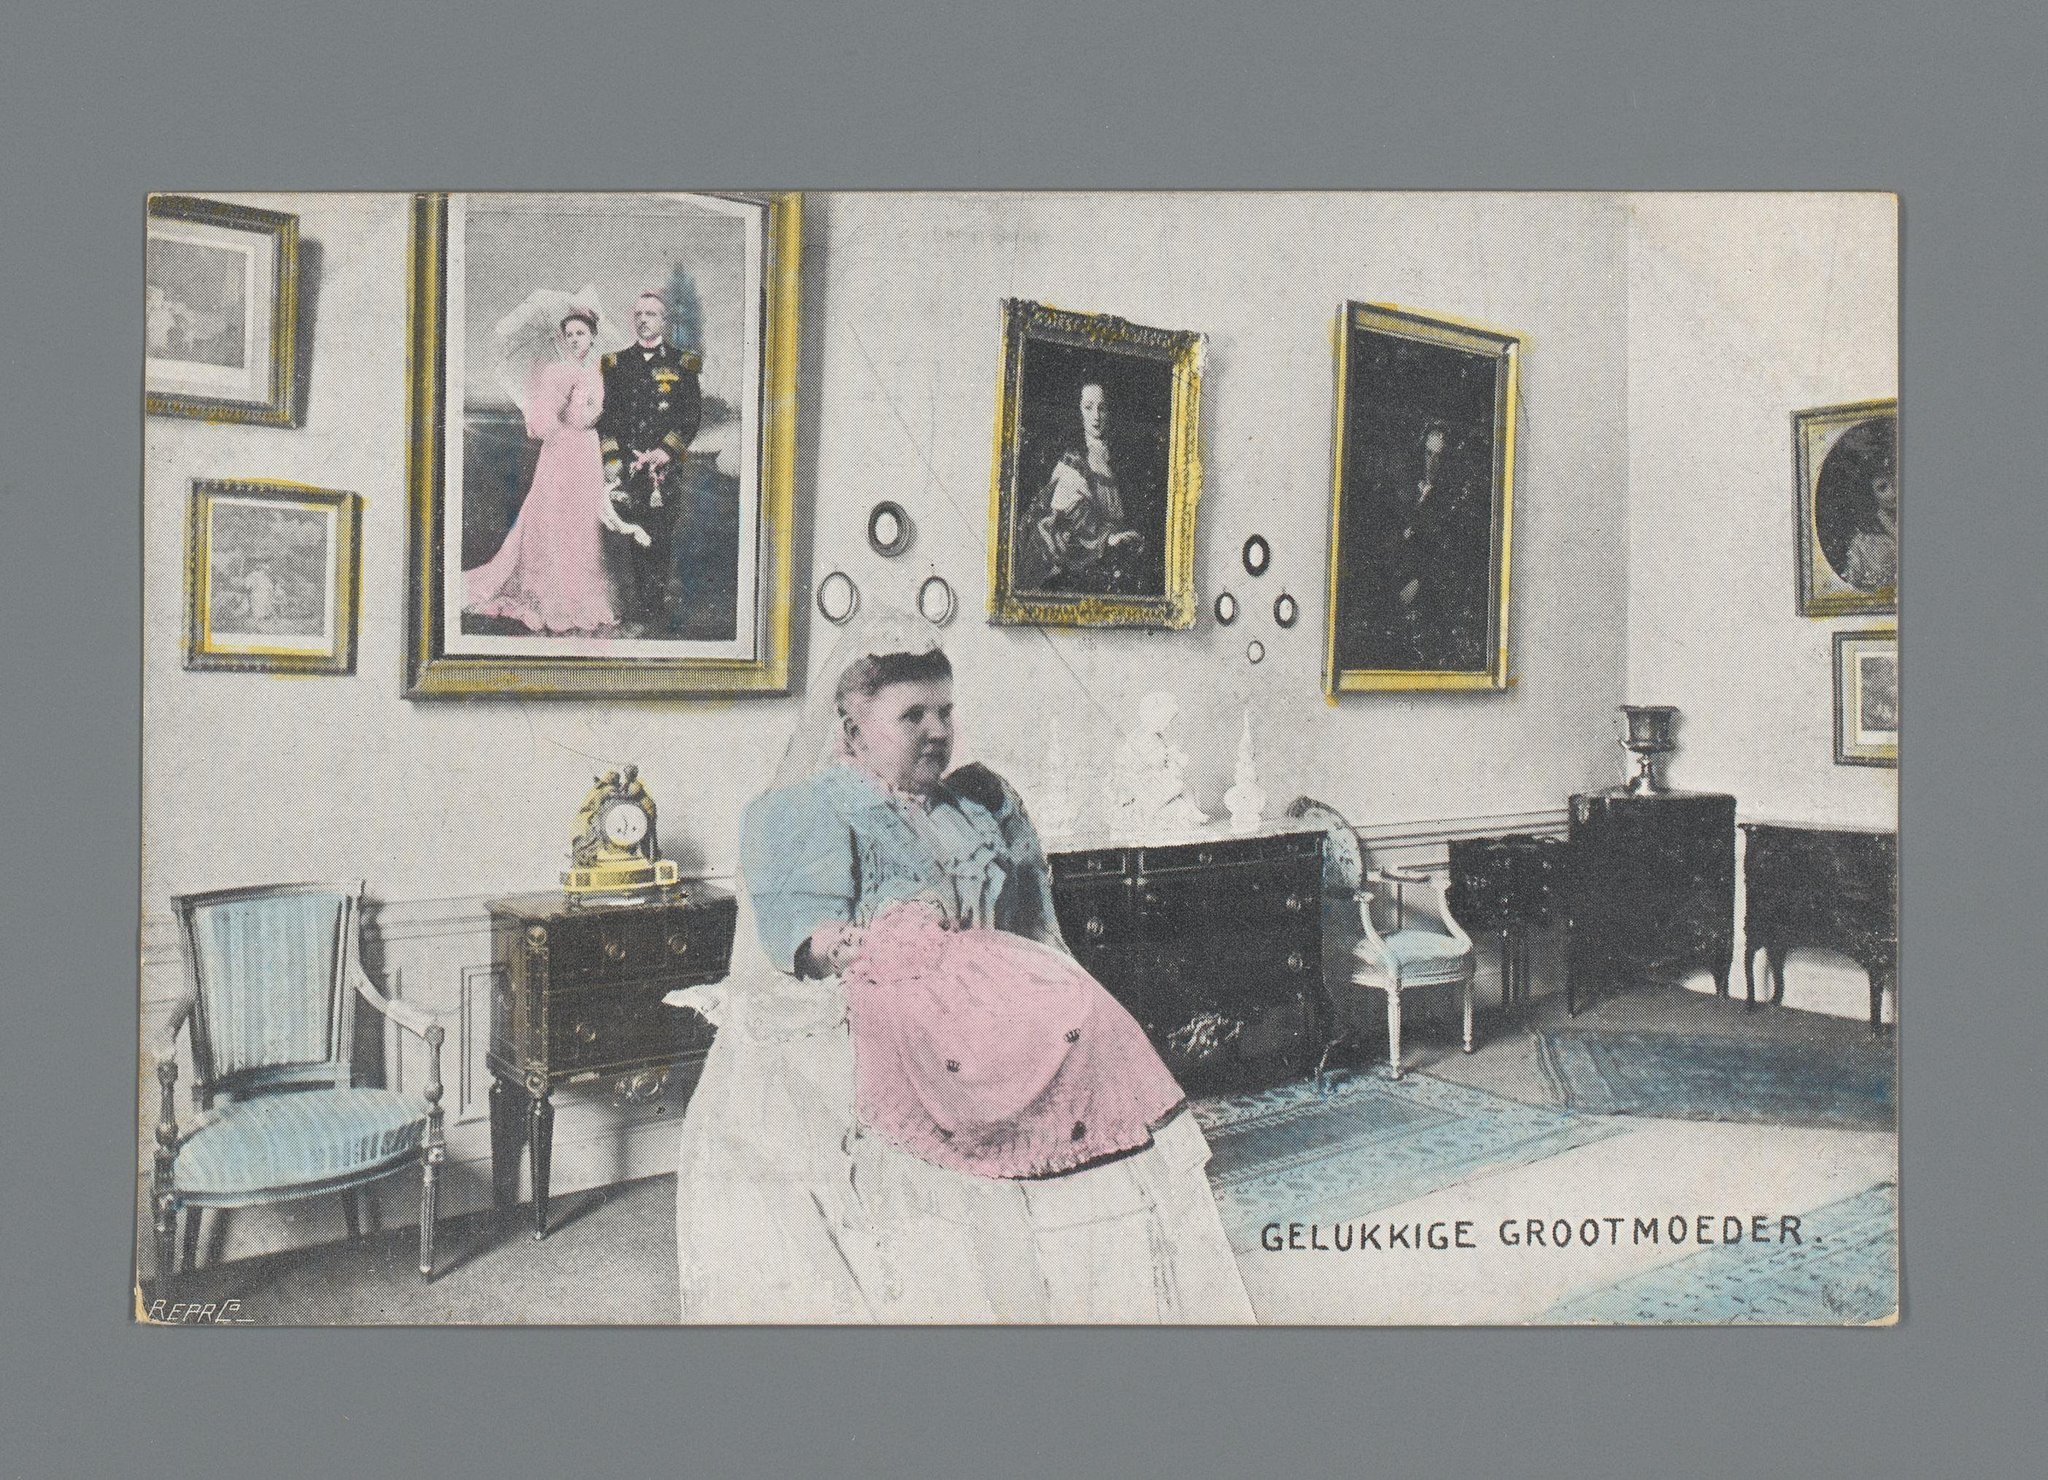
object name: photomechanical print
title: Gelukkige grootmoeder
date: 1905-1929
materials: paper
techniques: lithograph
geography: the hague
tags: old woman, anonymous historical person portrayed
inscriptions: inscription: ‘1.-’, inscription: ‘DRUKWERK.’